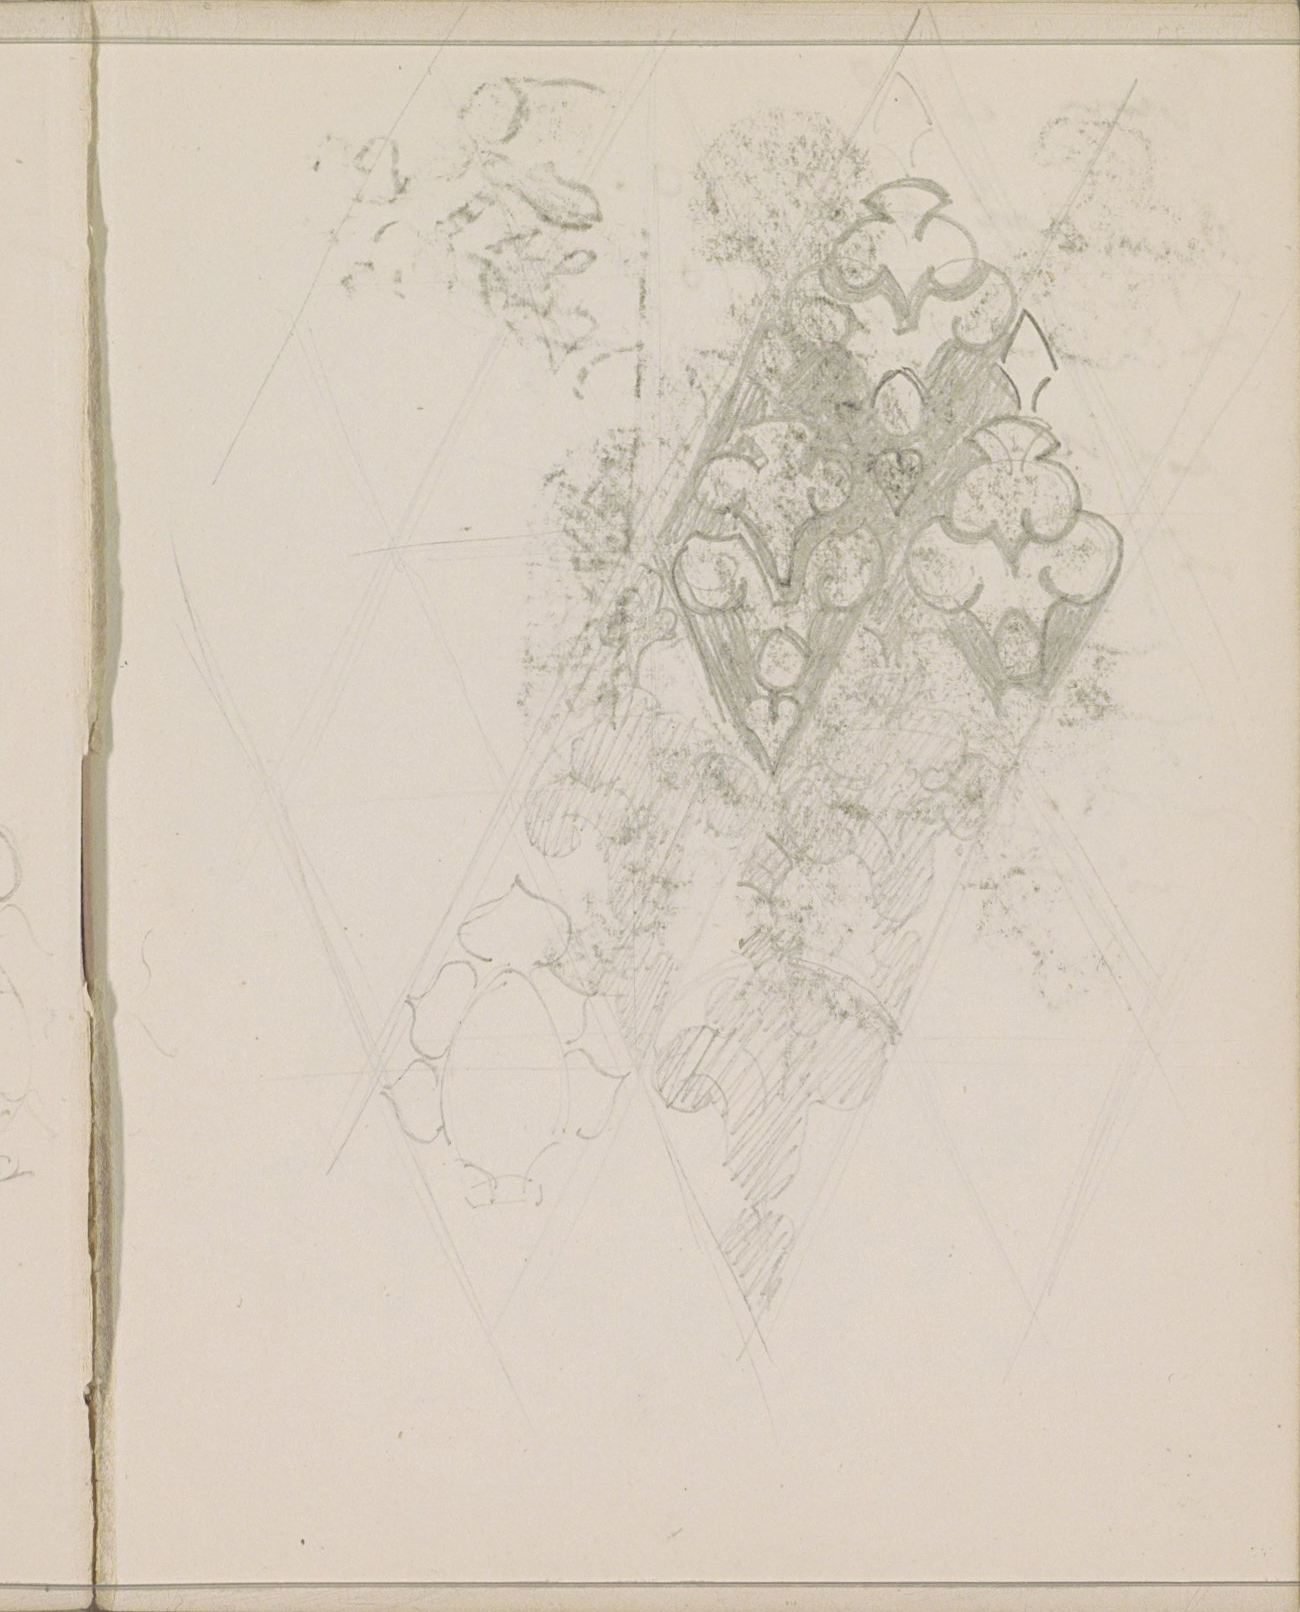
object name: sketchbook leaf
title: Fleur-de-lis ornament op een ruitpatroon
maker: reijer stolk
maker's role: draughtsman, print maker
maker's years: 1896-1945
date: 1916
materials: paper, pencil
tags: fleur-de-lis ~ ornament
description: Blad 16 recto uit een schetsboek met 72 bladen.